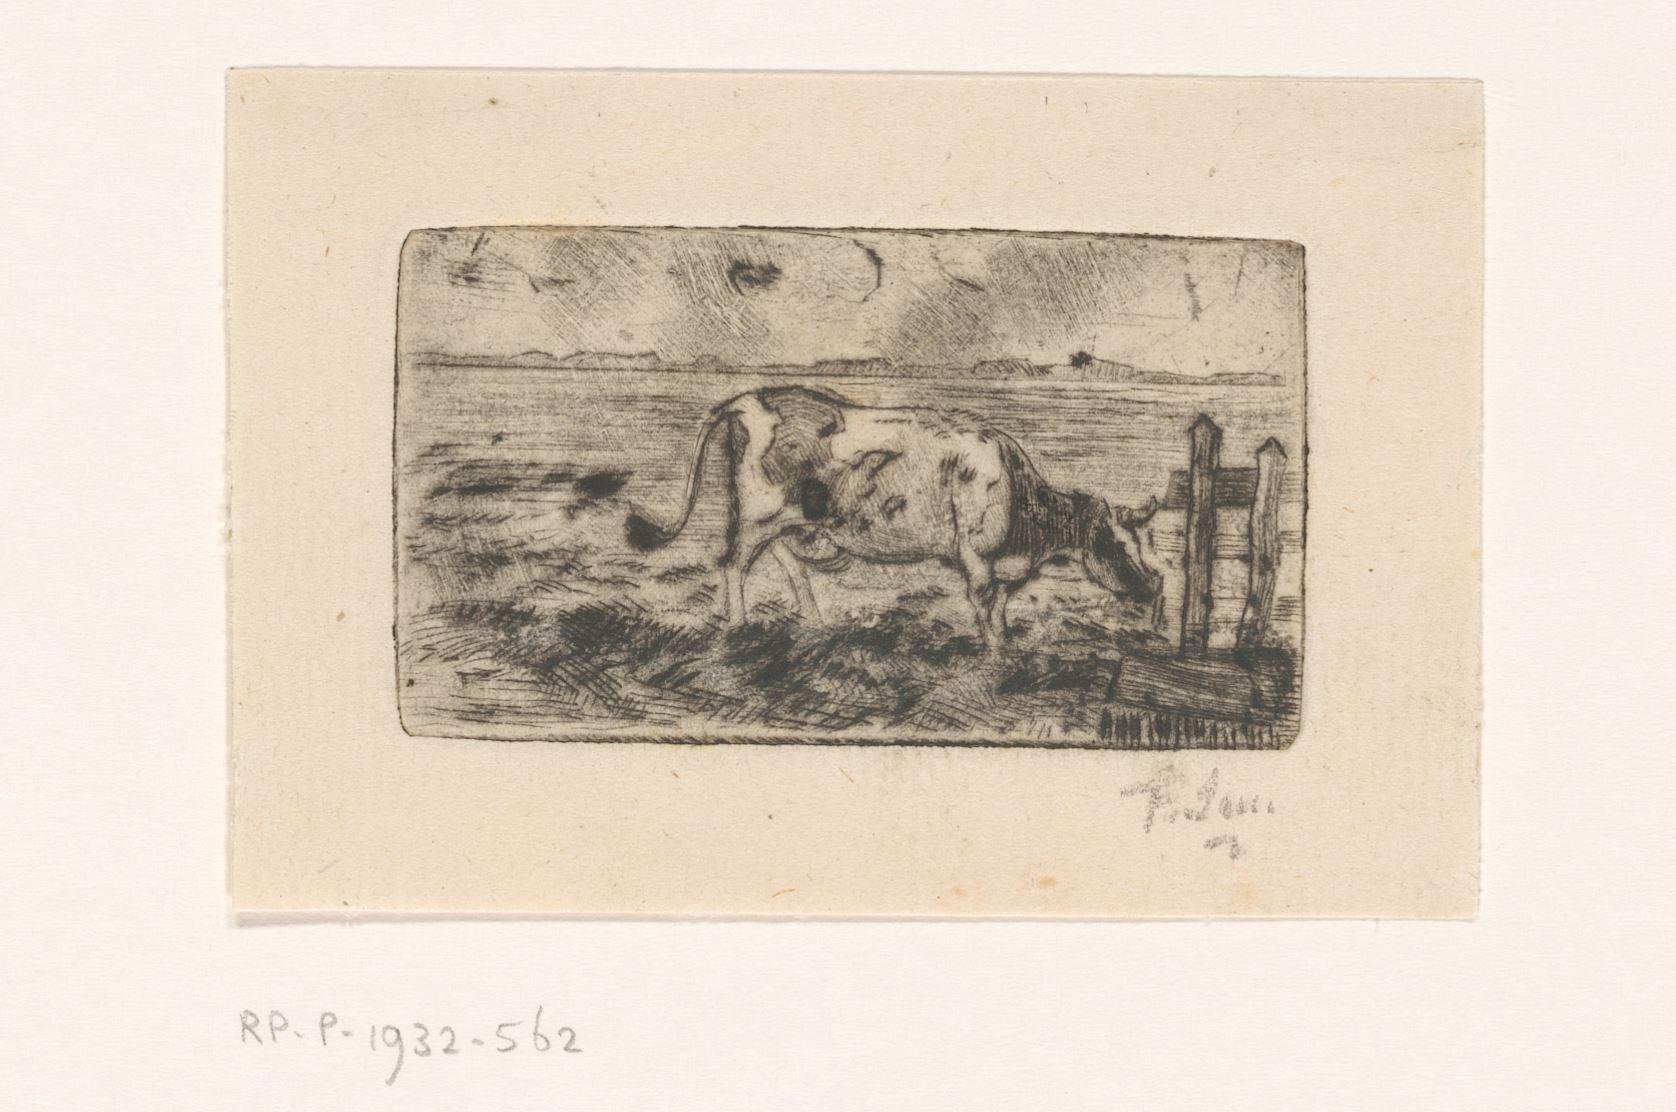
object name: print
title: Koe bij hek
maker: frans smissaert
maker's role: draughtsman, print maker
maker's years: 1862-1944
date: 1872-1932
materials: paper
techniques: etching, intaglio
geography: netherlands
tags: cow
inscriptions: collector's mark: Lugt 2228